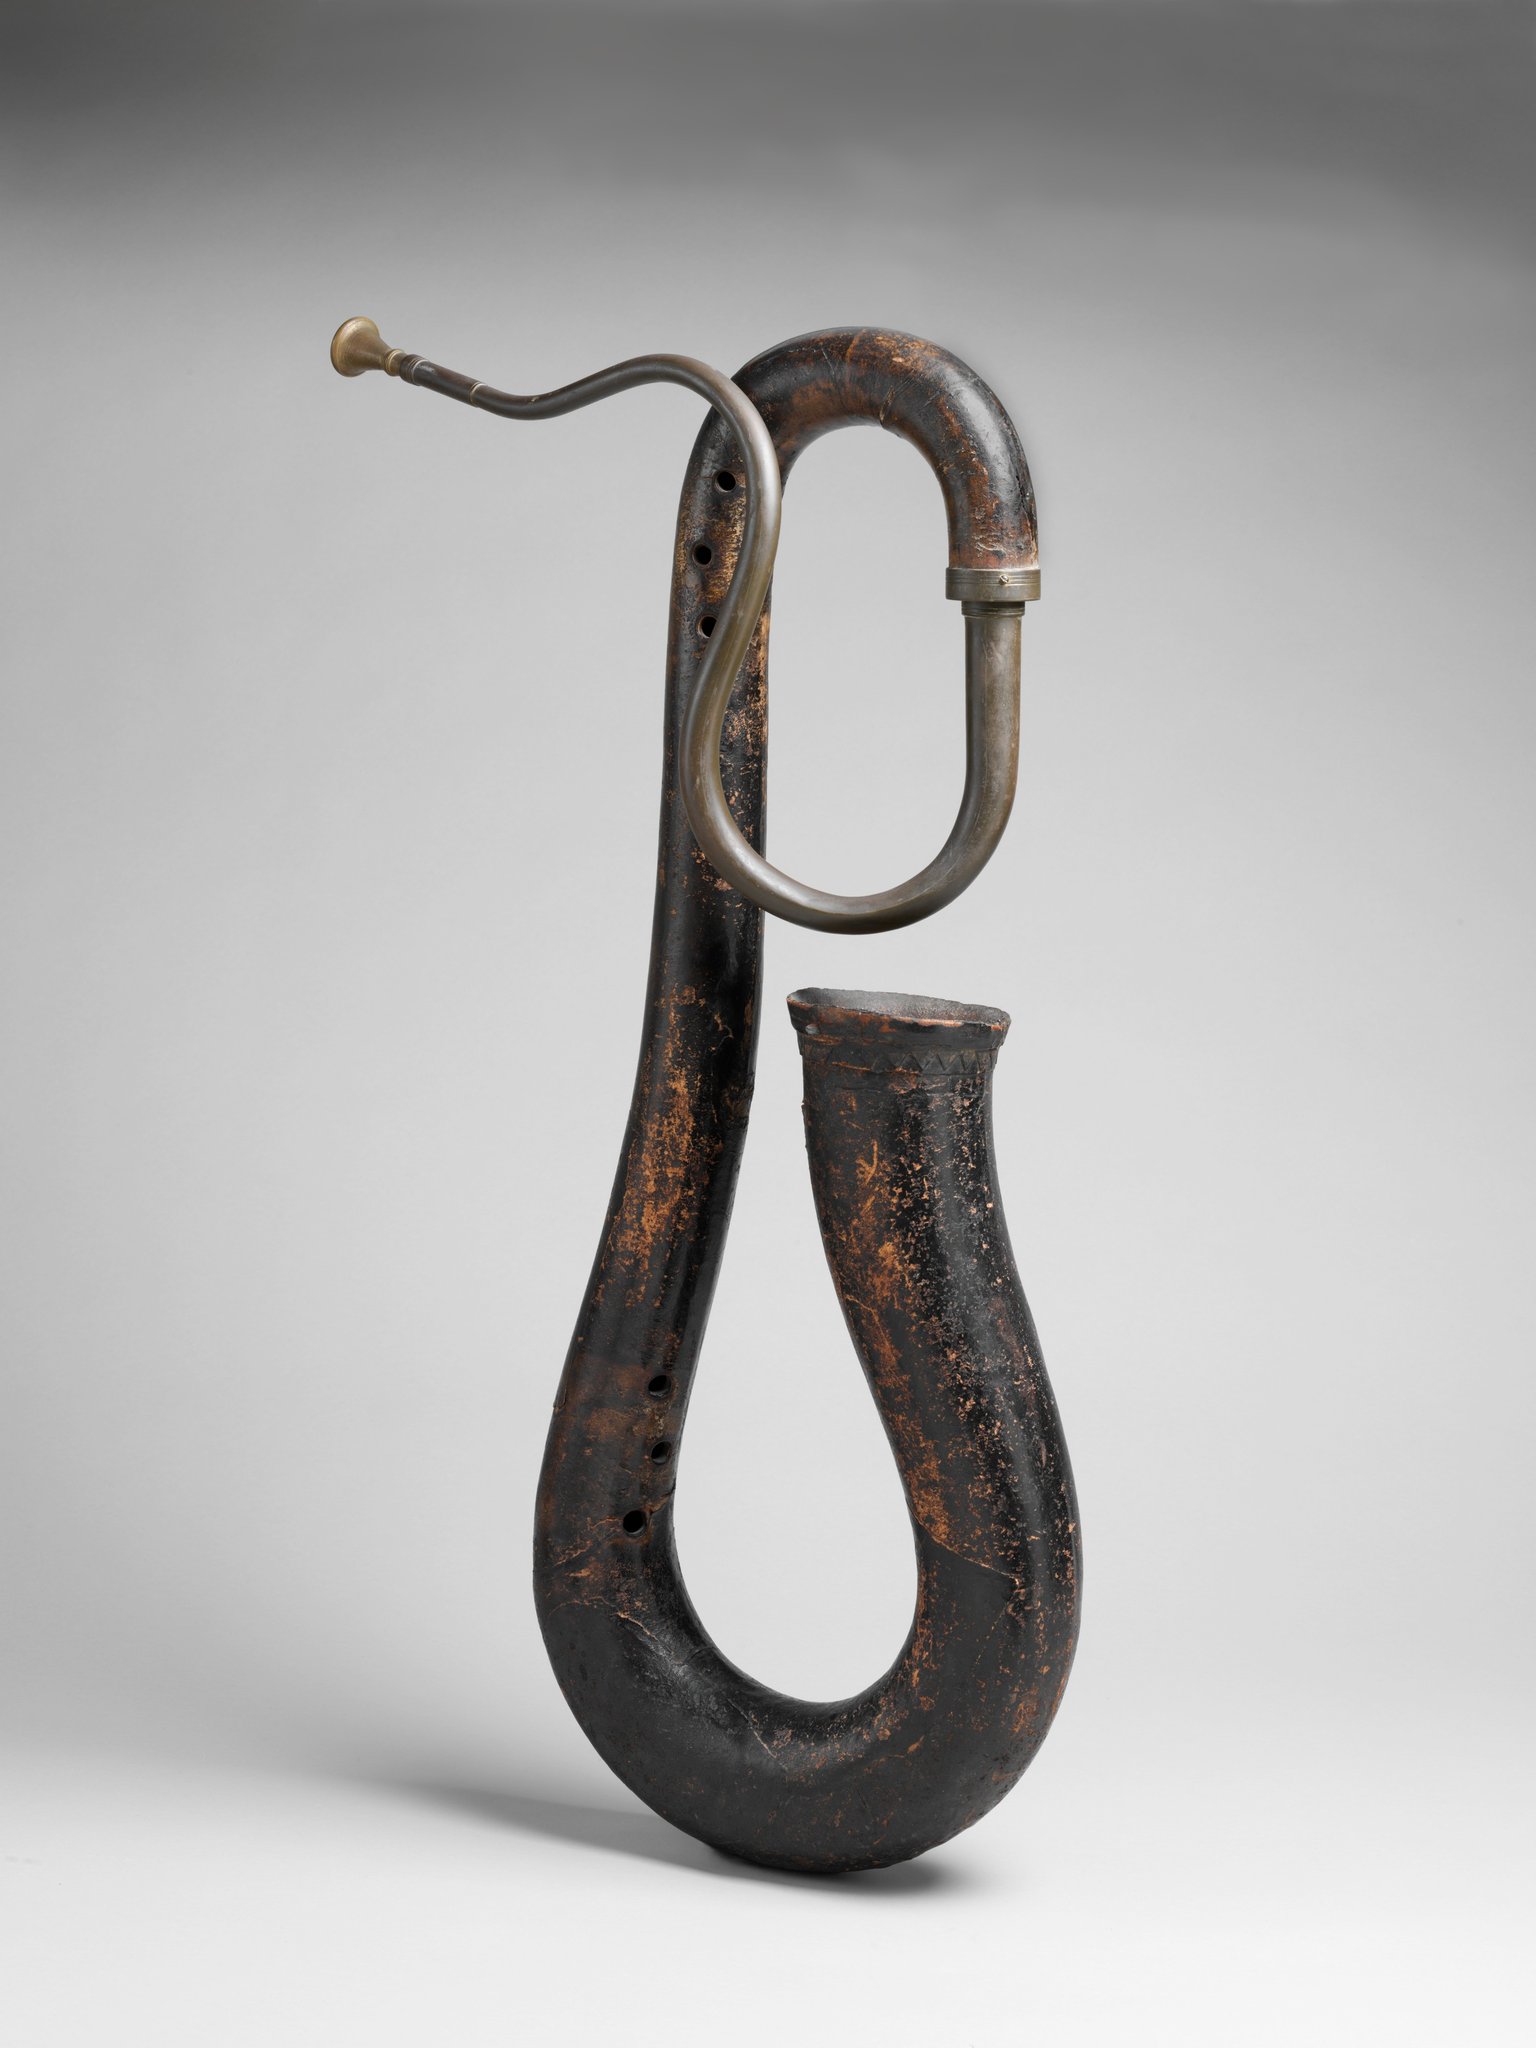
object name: serpent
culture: french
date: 1810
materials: leather, metal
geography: france